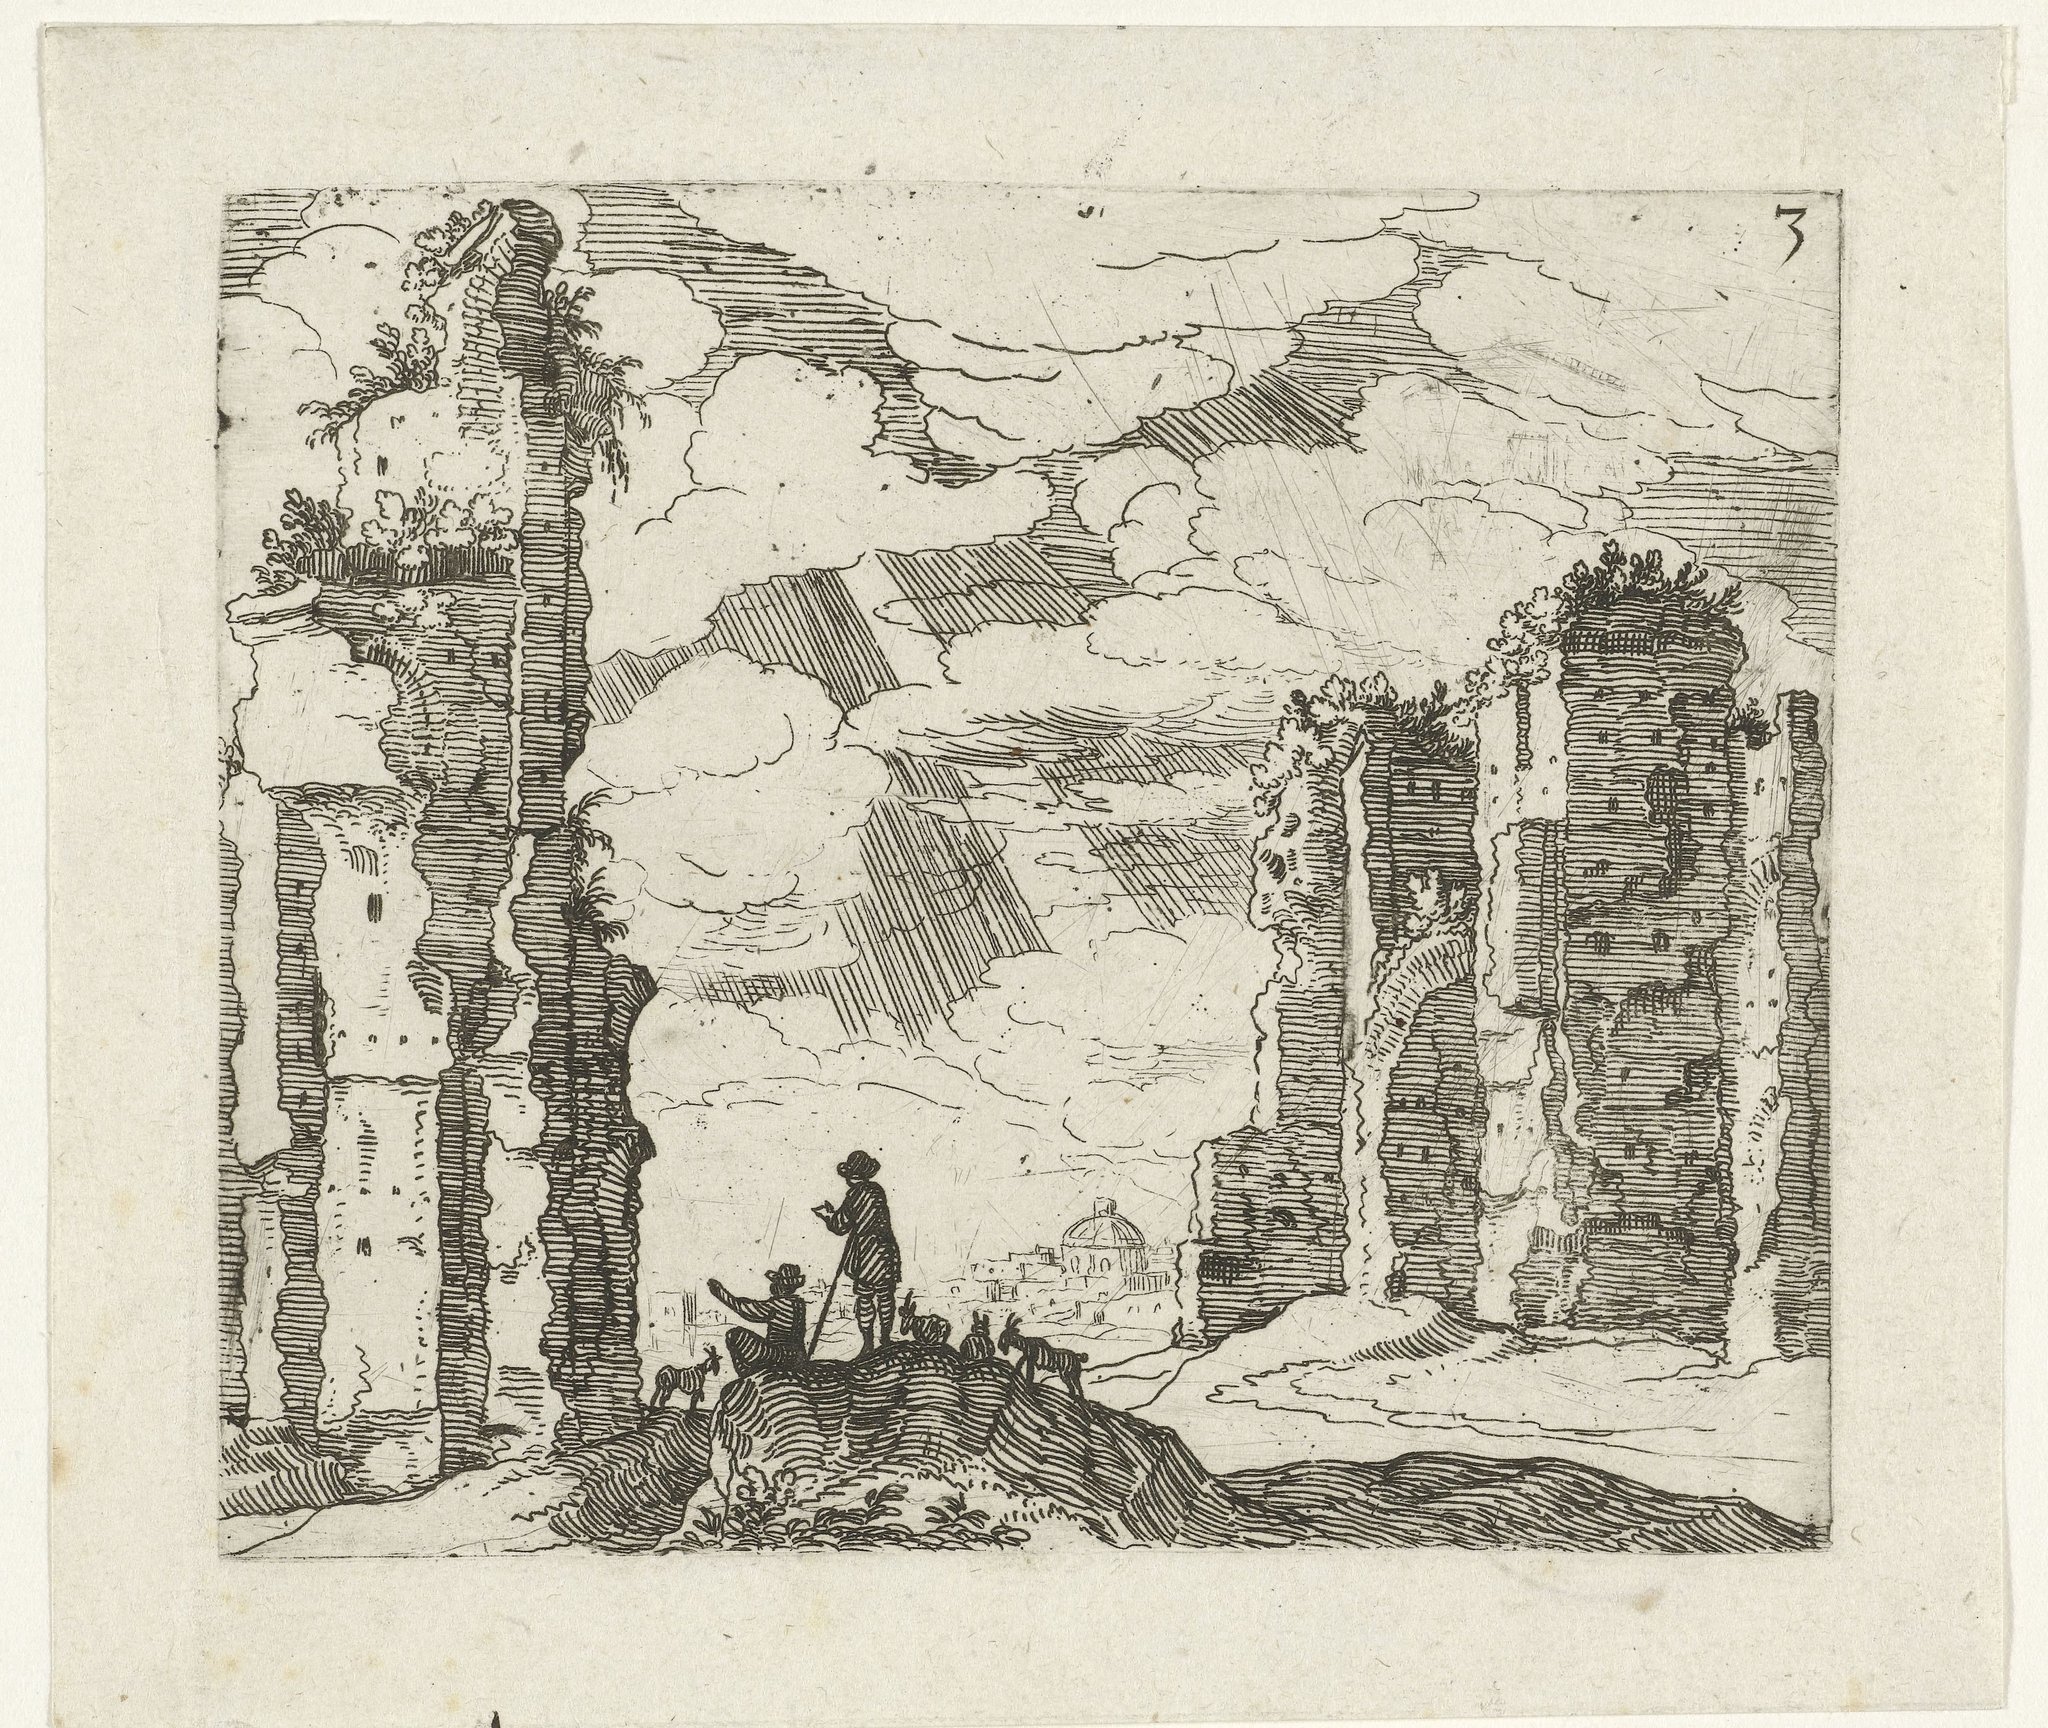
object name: print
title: Romeinse ruïnes (serie 1)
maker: guilliam van nieulandt (ii)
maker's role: draughtsman, print maker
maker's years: 1584-1635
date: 1594-1618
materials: paper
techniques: etching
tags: herding, herdsman, herdswoman, shepherd, shepherdess, cowherd, etc., landscape with ruins (+ city(-scape) with figures, staffage), rome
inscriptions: collector's mark: Lugt 240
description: De begroeide ruïnes van de thermen van Caracalla in Rome. Op de voorgrond twee herders met een kudde geiten. Op de achtergrond de stad Rome. Prent uit een serie Romeinse ruïnes.